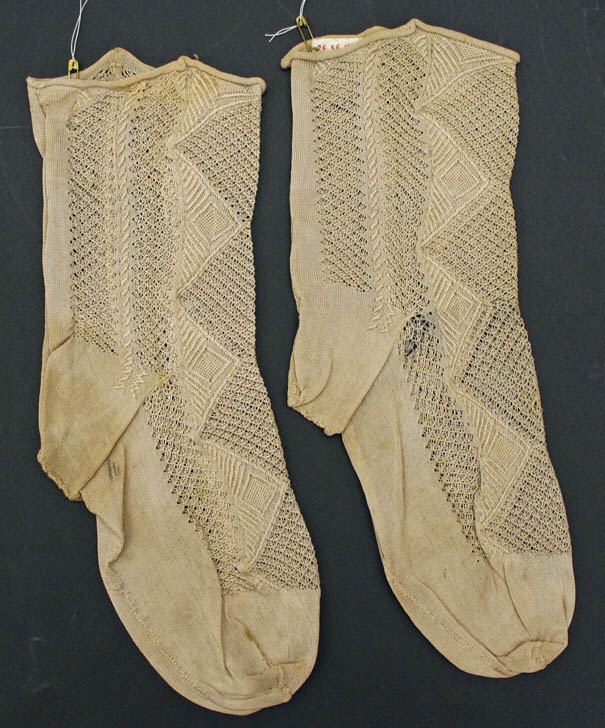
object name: sock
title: Socks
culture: italian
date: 1801-1833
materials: silk